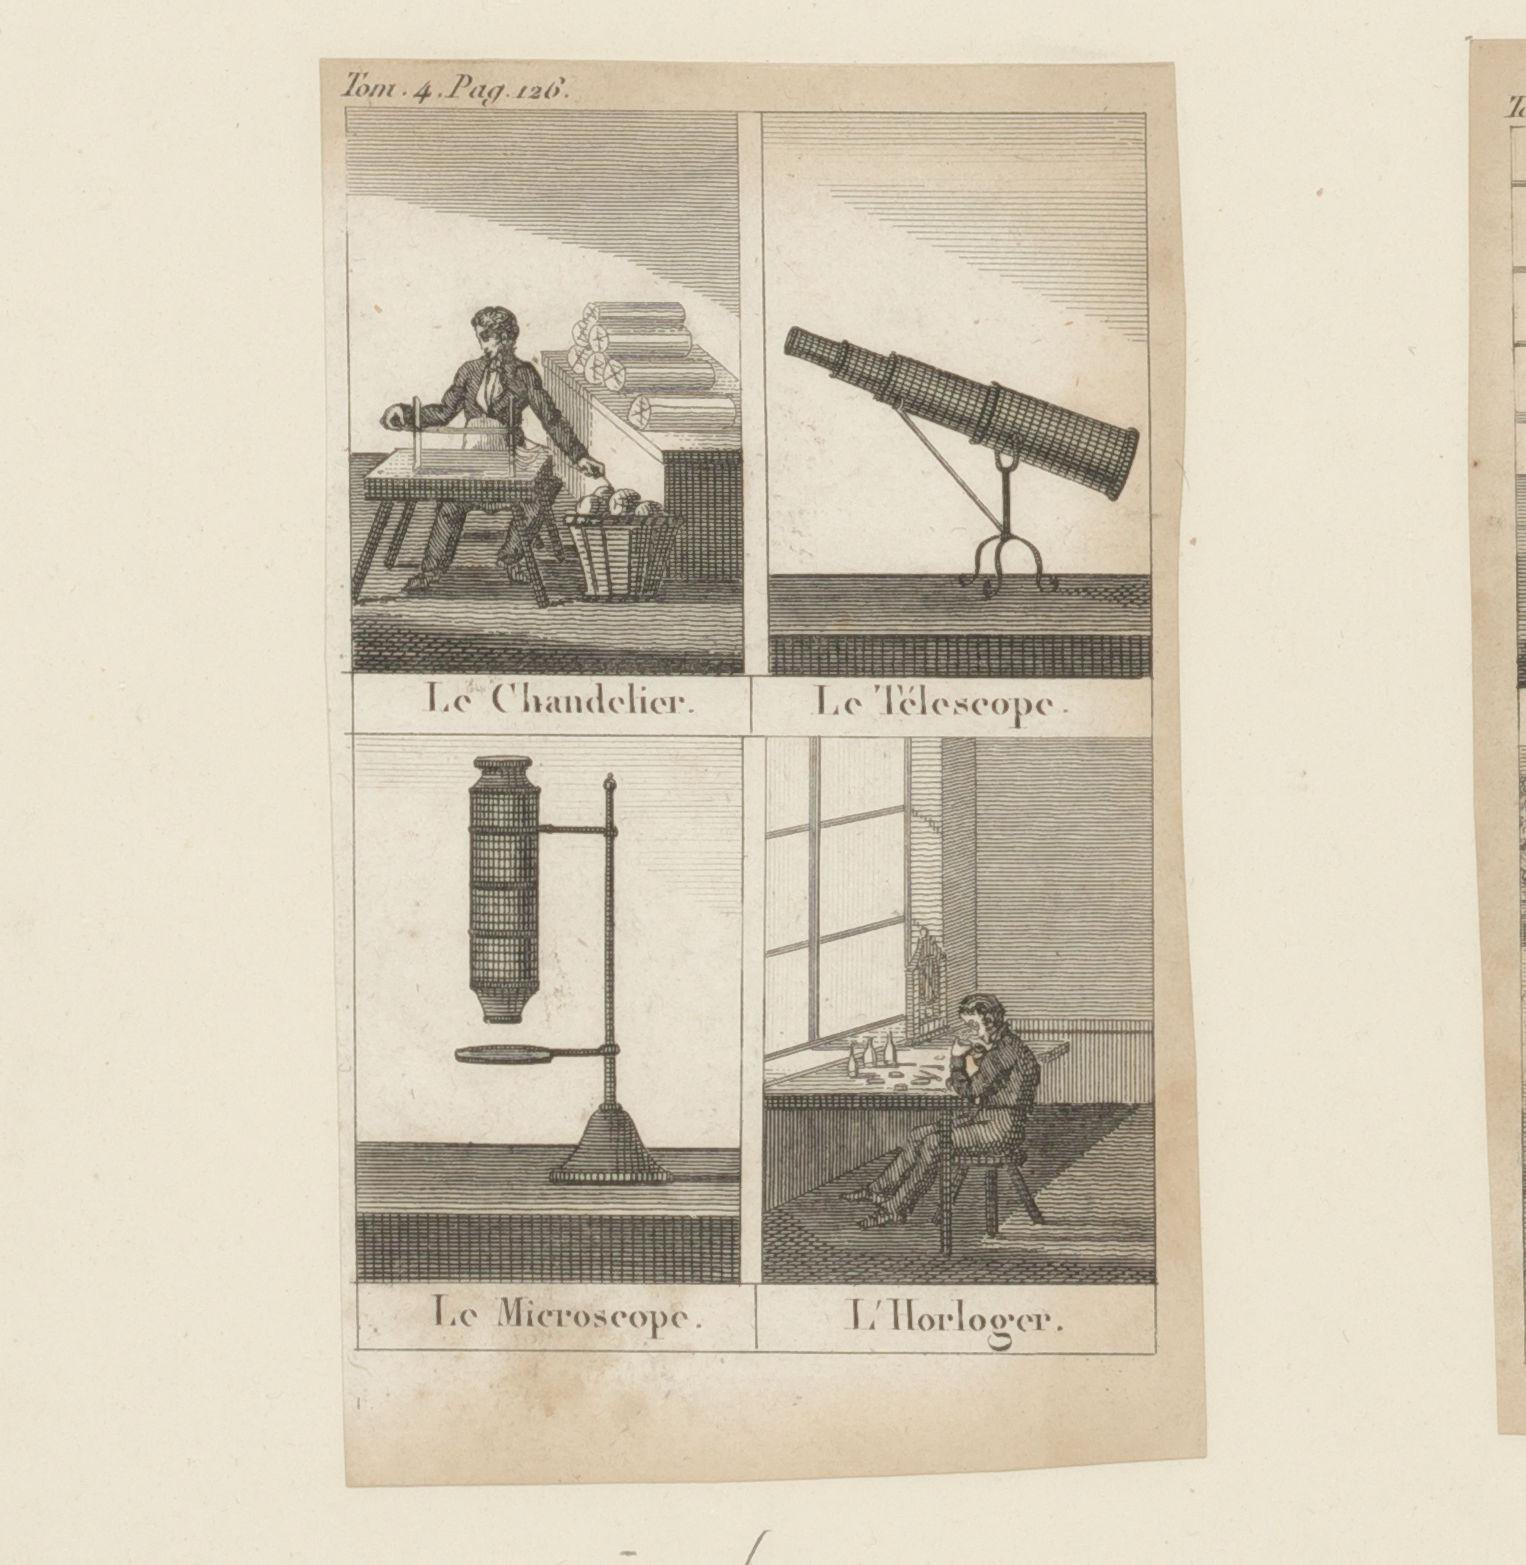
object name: print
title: Kaarsenhouder, telescoop, microscoop en de horlogemaker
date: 1816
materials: paper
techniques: etching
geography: paris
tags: handicrafts, craftsman at work, telescope, watch, watchmaker, clockmaker, microscope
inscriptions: stamp, collector's mark: Lugt 1641a, collector's mark: Lugt 1641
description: Vier voorstellingen van instrumenten en instrumentmakers: kandelaar, telescoop, microscoop en de horlogemaker. Bovenaan genummerd: Tom. 4. Pag. 126. Onderwerpsrubrieken binnen de Atlas Zeden en Gewoonten: Handel, Nijverheid en Verkeer, Beroep en Bedrijf, Mannelijk, Complete suites.